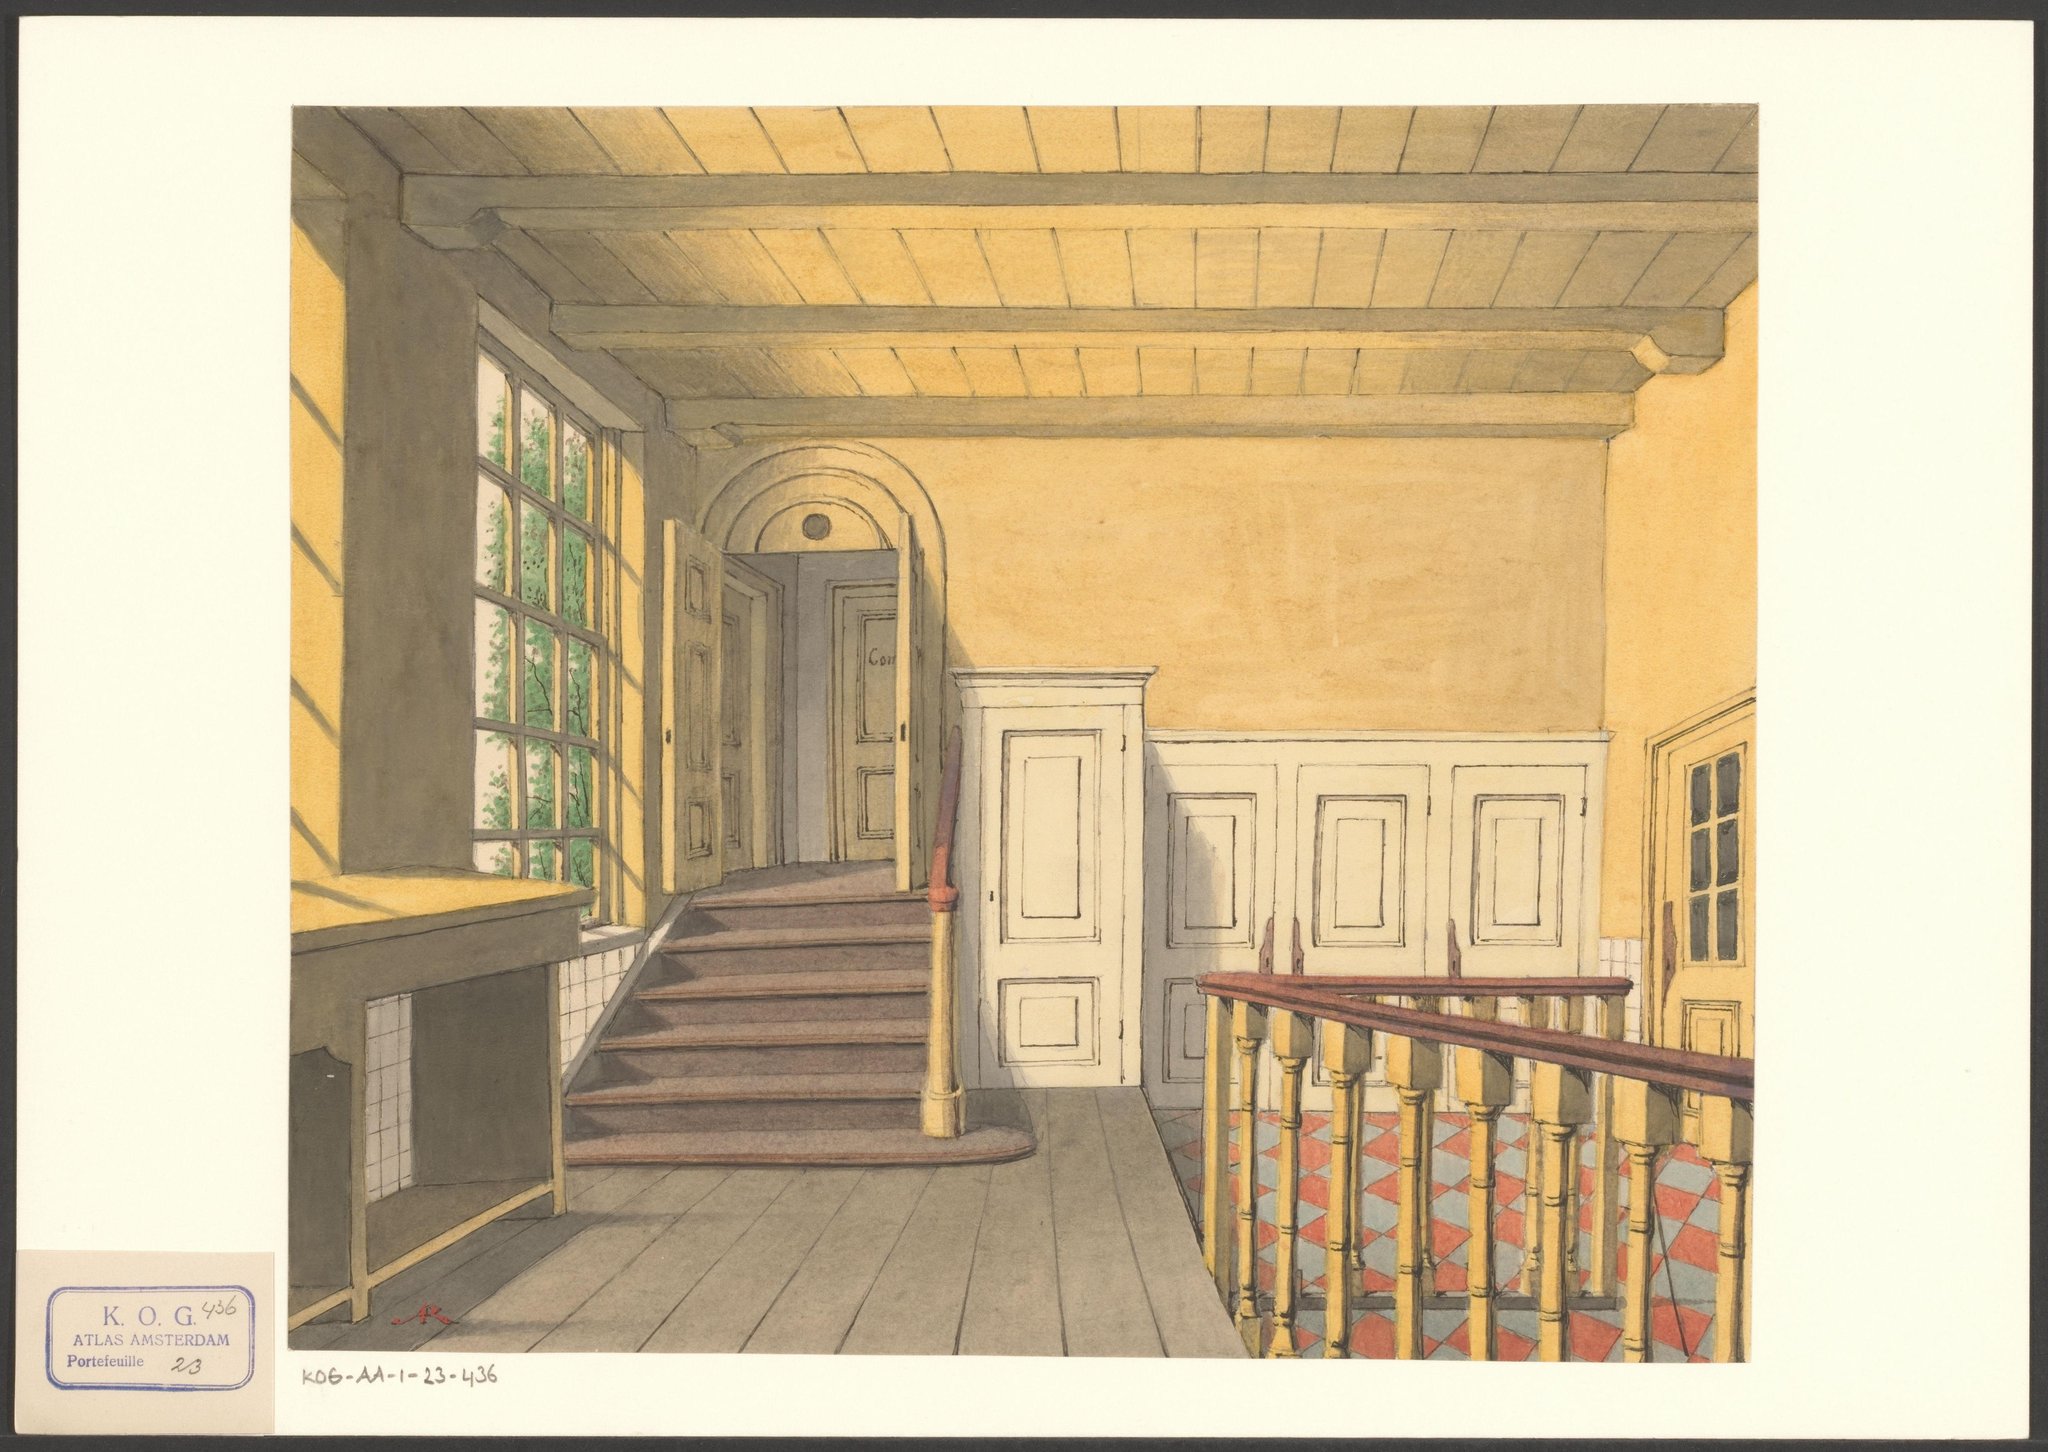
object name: drawing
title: Gezicht op de toegang tot de Commissiekamer van het Tucht- of Rasphuis aan de Heiligeweg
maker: johan martinus anthon rieke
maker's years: 1851-1899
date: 1895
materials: gouache, ink, paper, pencil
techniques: brush, pen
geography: amsterdam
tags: prison, jail, gate, entrance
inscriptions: collector's mark: ‘23’ Lugt 1641b, inscription: ‘Port. 23-436’, signature, date and inscription: ‘Toegang tot de (...) fecit 1895 Amsterdam’, signature: ‘JMAR’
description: Onderwerpsrubriek binnen de Atlas Amsterdam: Handvesten, Keuren, enz.; Rechtswezen (incl. gevangenissen, enz.).